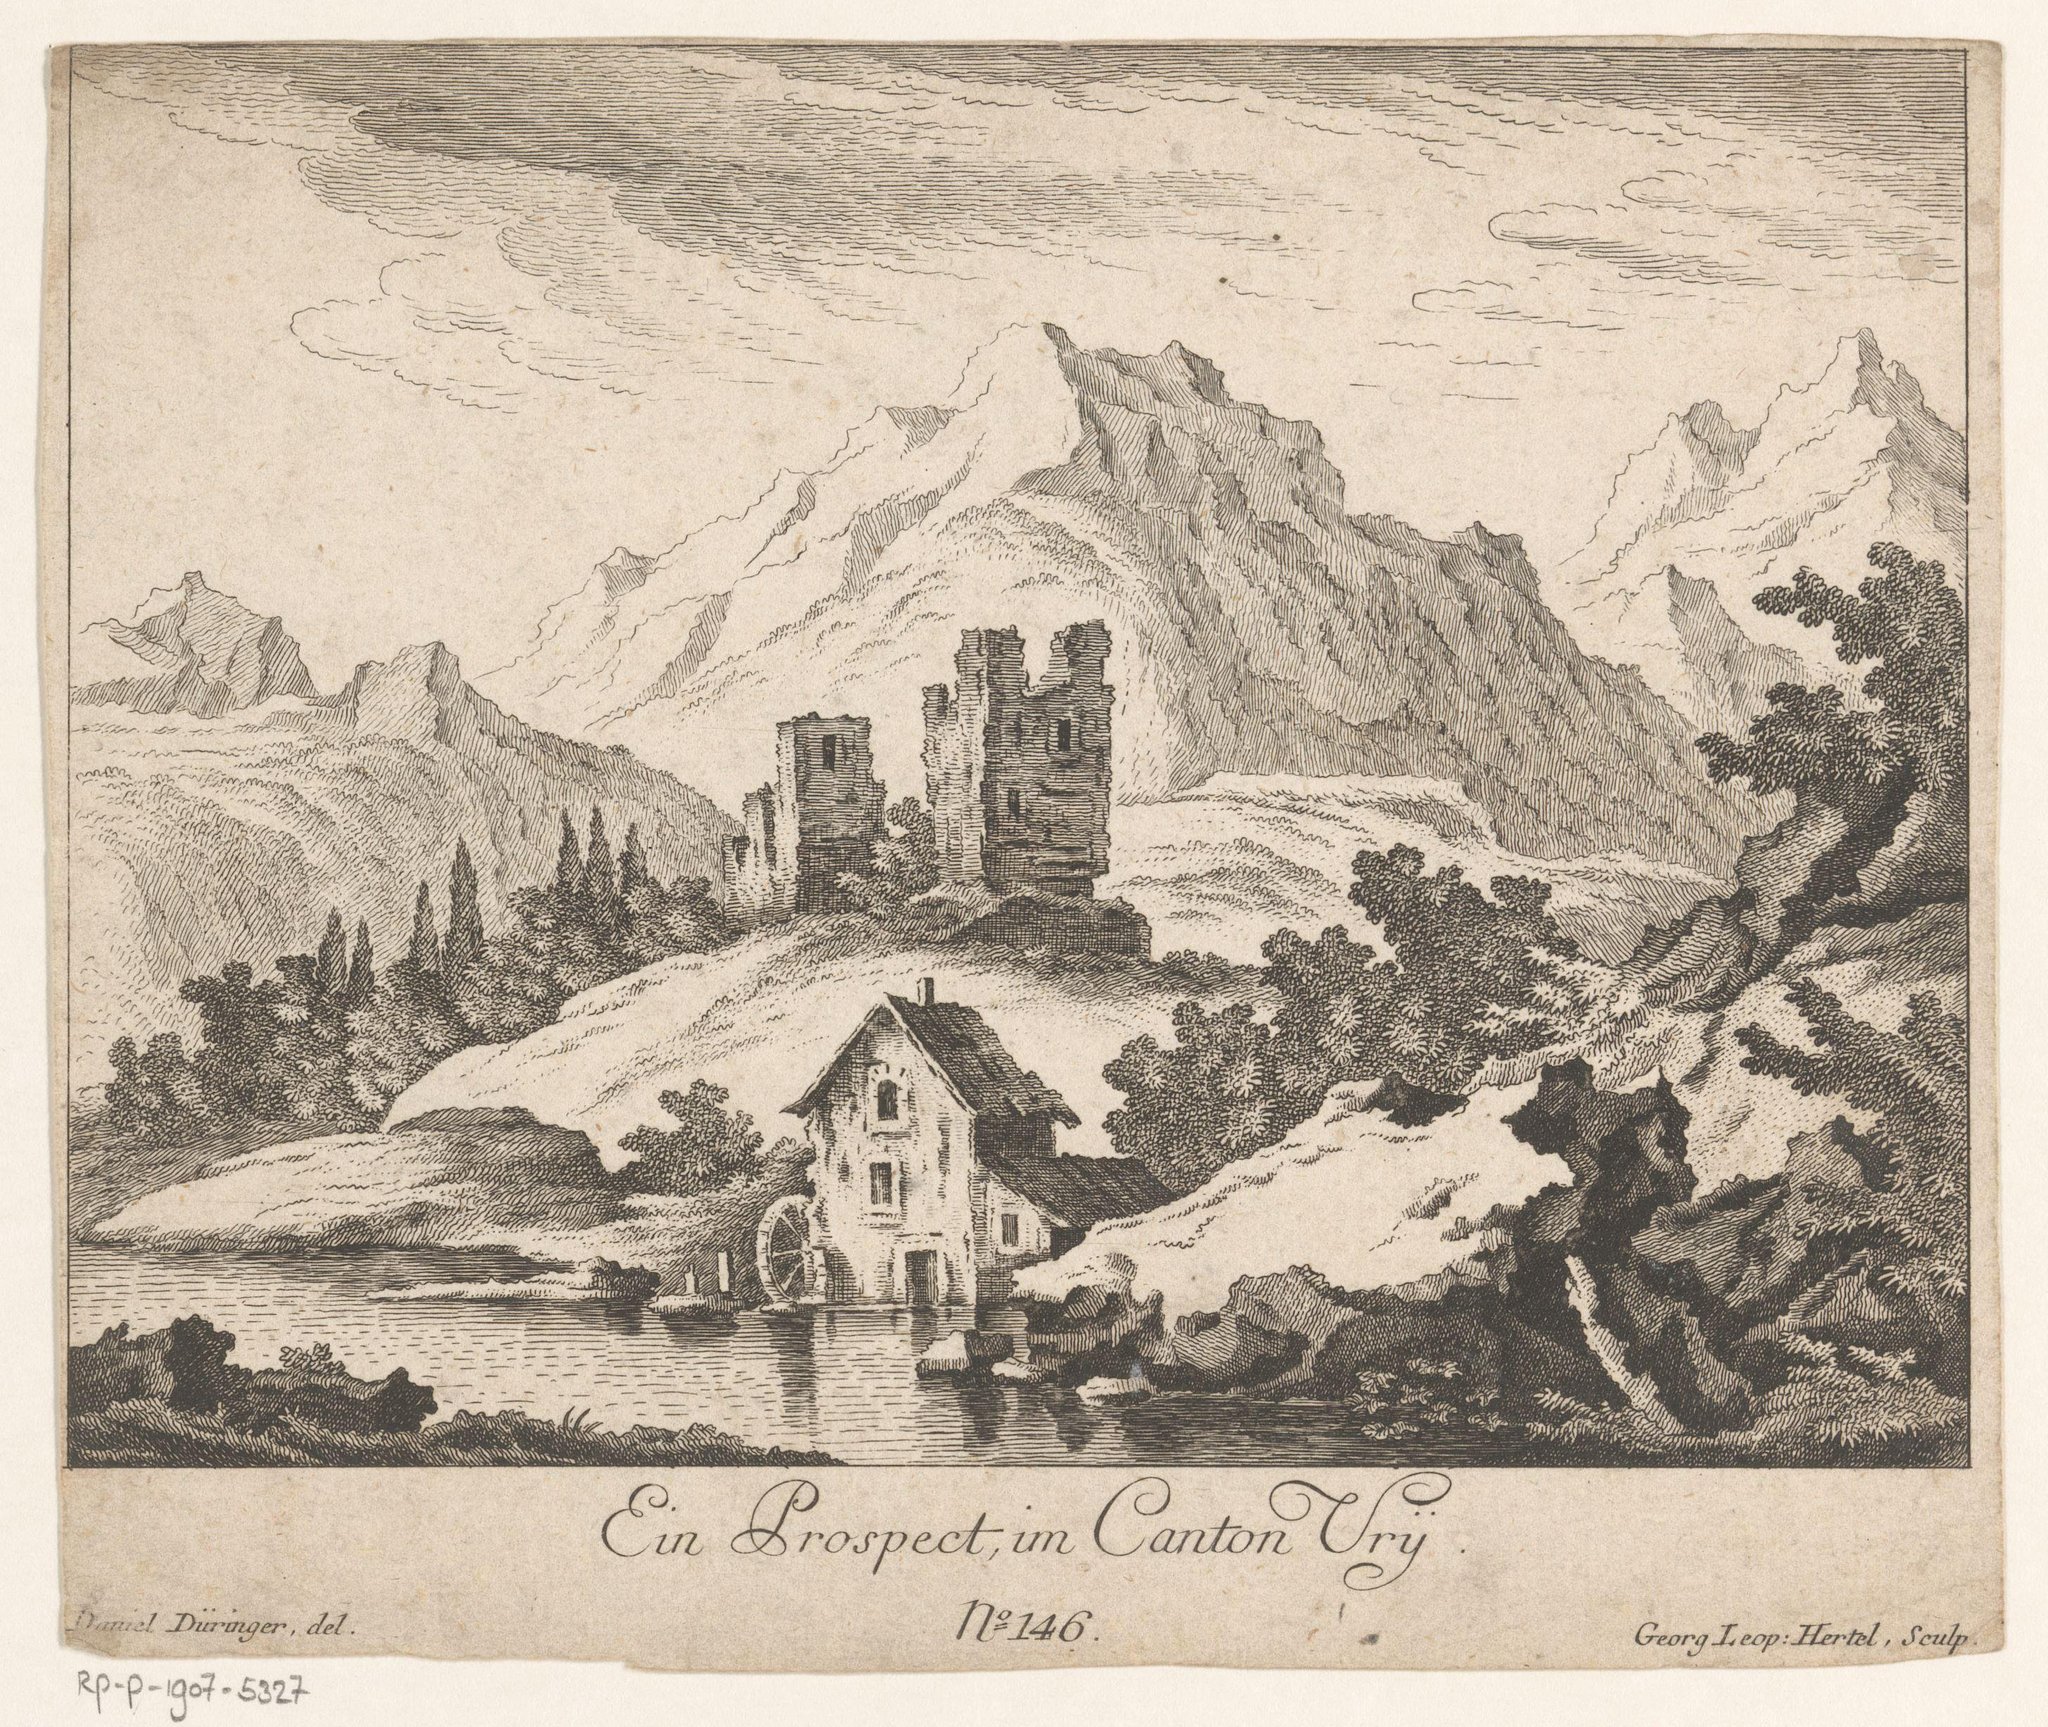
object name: print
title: Ein Prospect, im Canton Vrij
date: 1750-1778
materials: paper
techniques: etching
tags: landscape with ruins, watermill, mountains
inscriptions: collector's mark: Lugt 2228